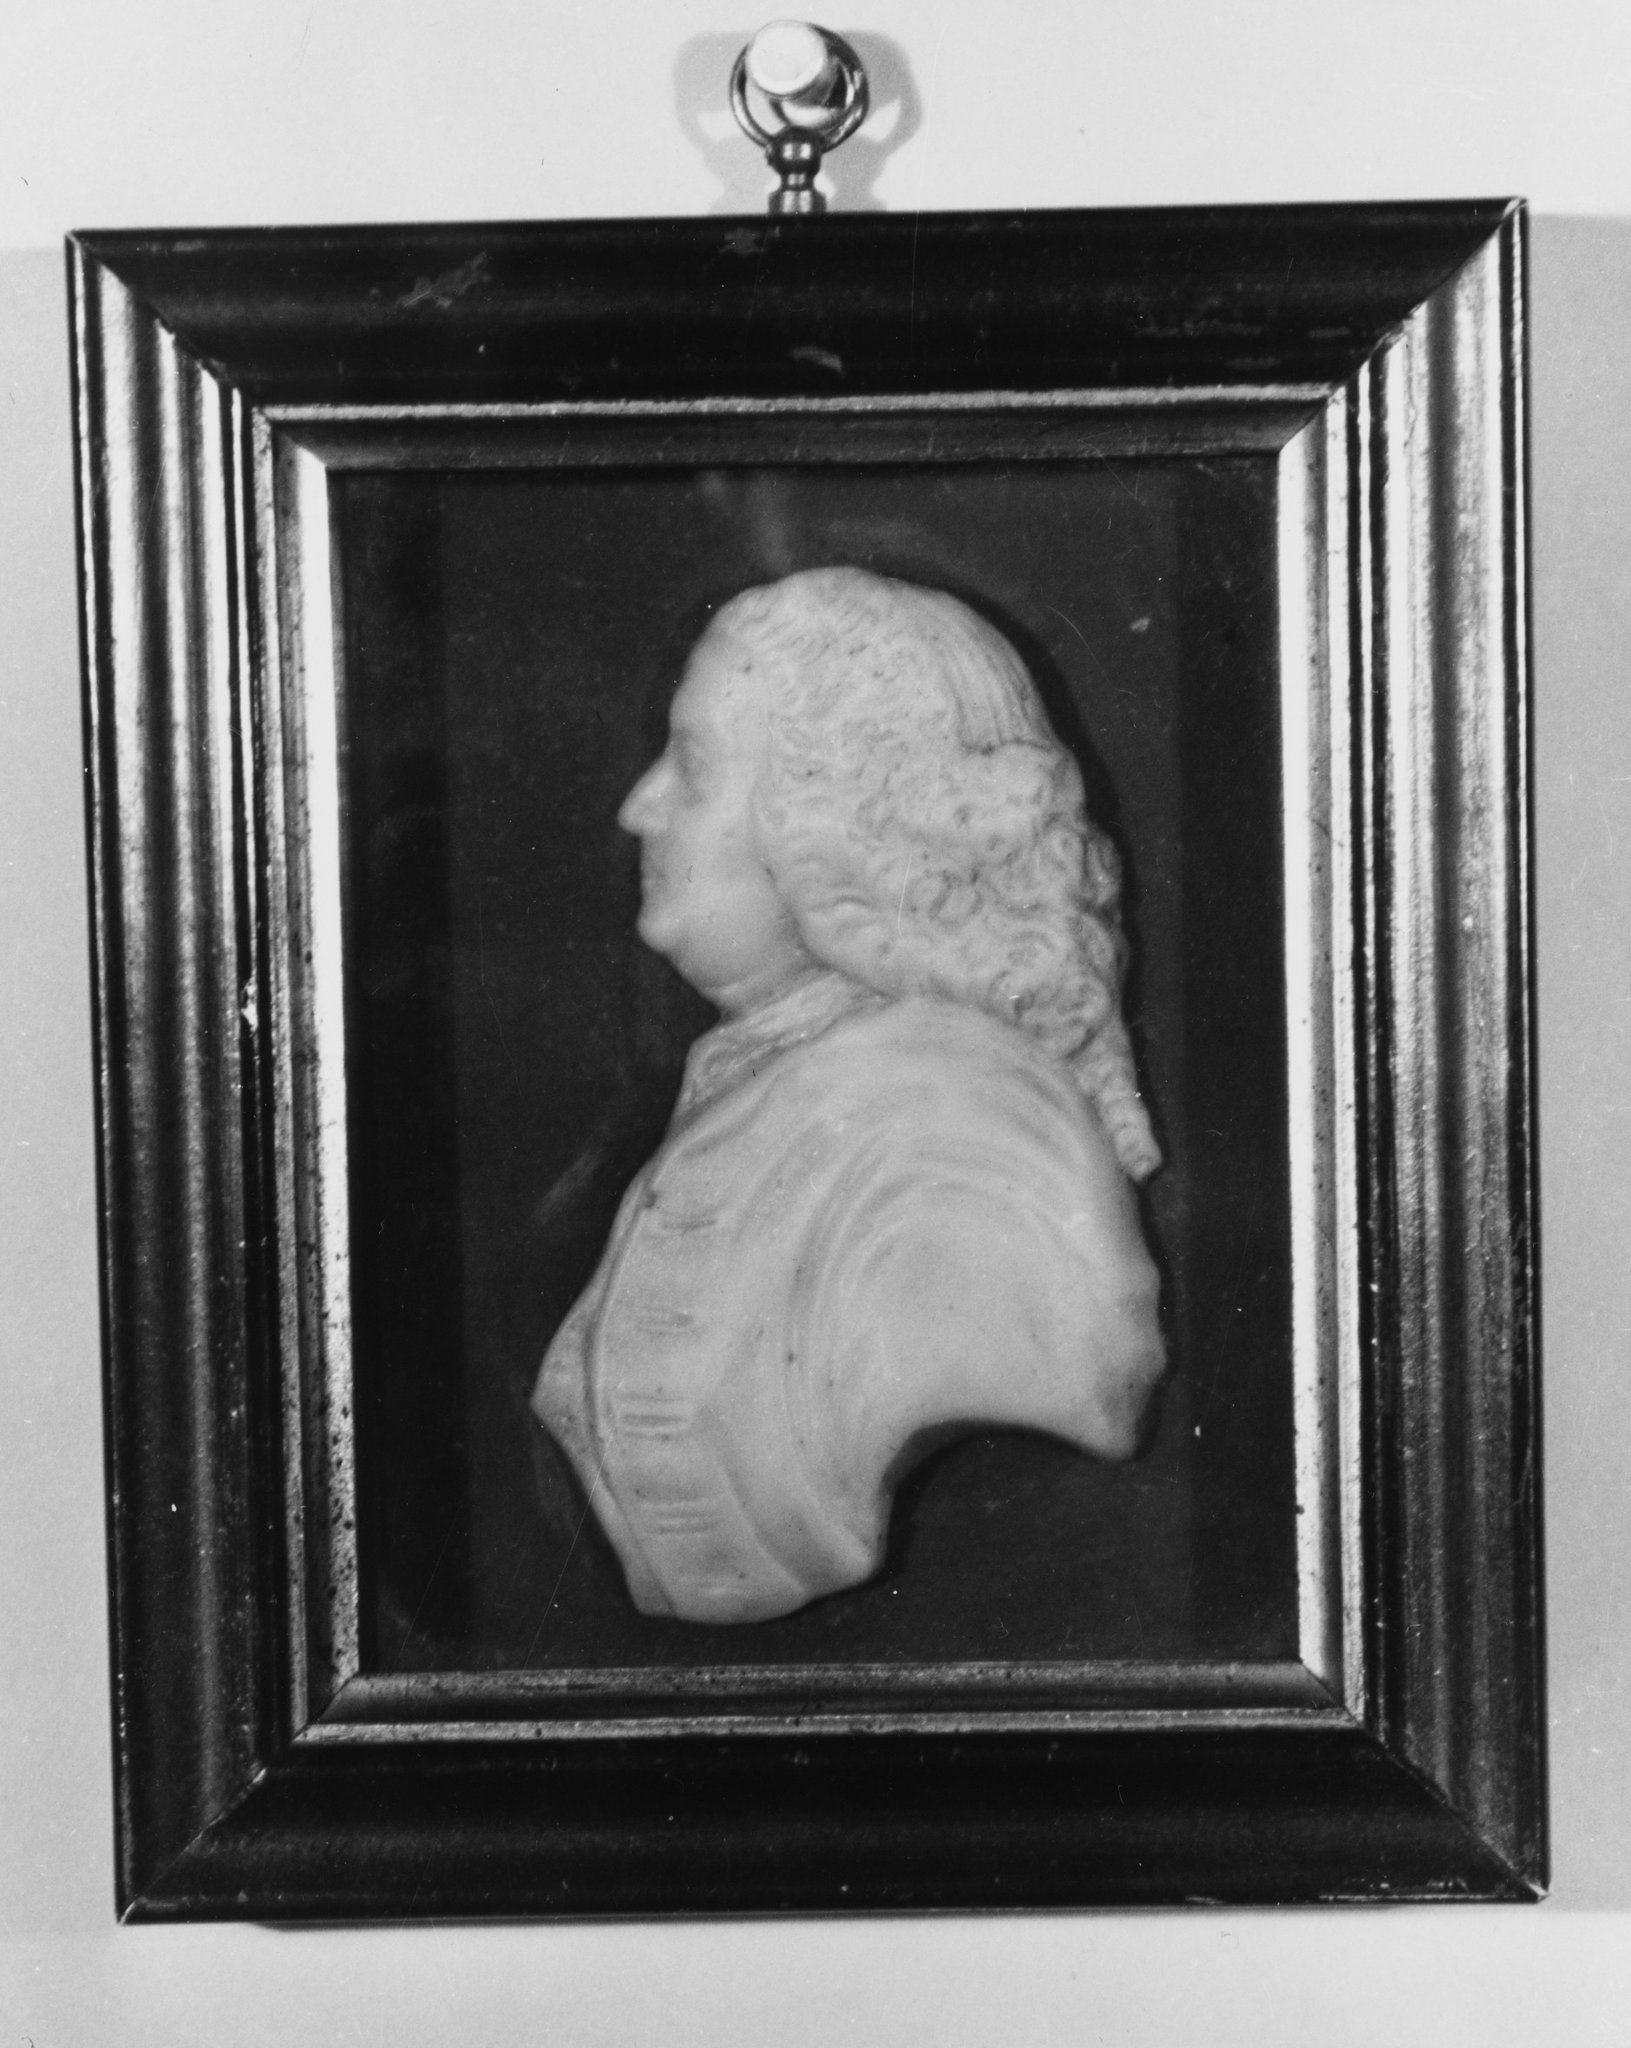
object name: bust, miniature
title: Profile Bust of Benjamin Franklin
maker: patience wright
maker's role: maker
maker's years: 1725-1786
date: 1775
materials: glass, paper, wax, wood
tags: benjamin franklin,profiles